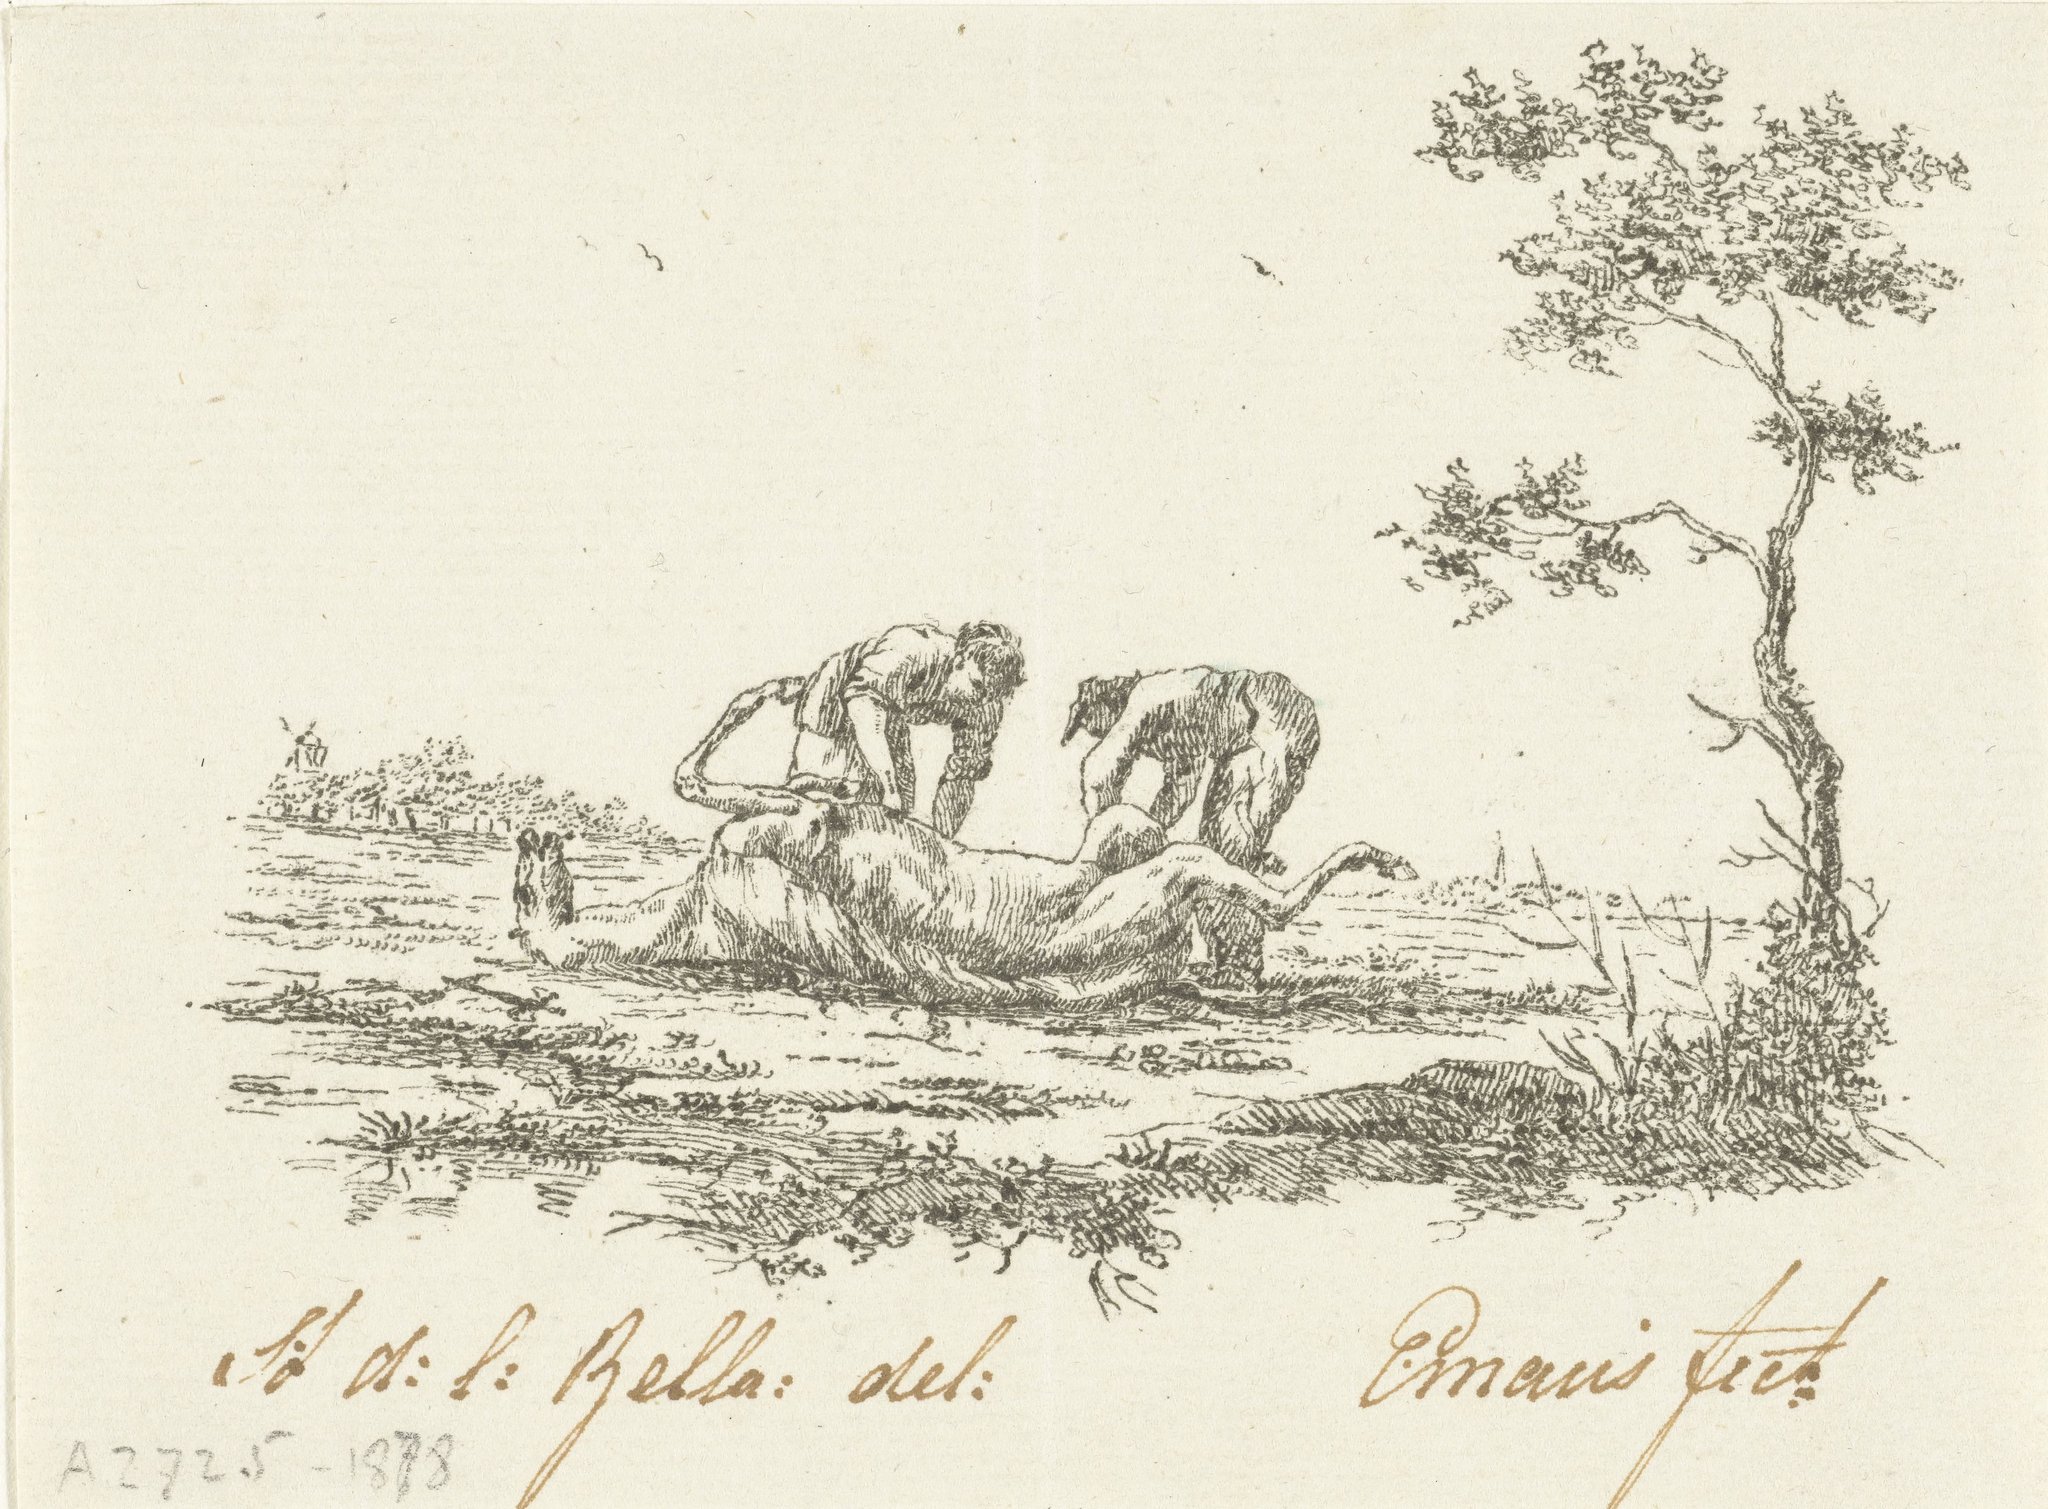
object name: print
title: De vilders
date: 1813-1863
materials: paper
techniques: etching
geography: amsterdam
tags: animals (+ shedding of skin of animal(s))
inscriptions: collector's mark: Lugt 2228